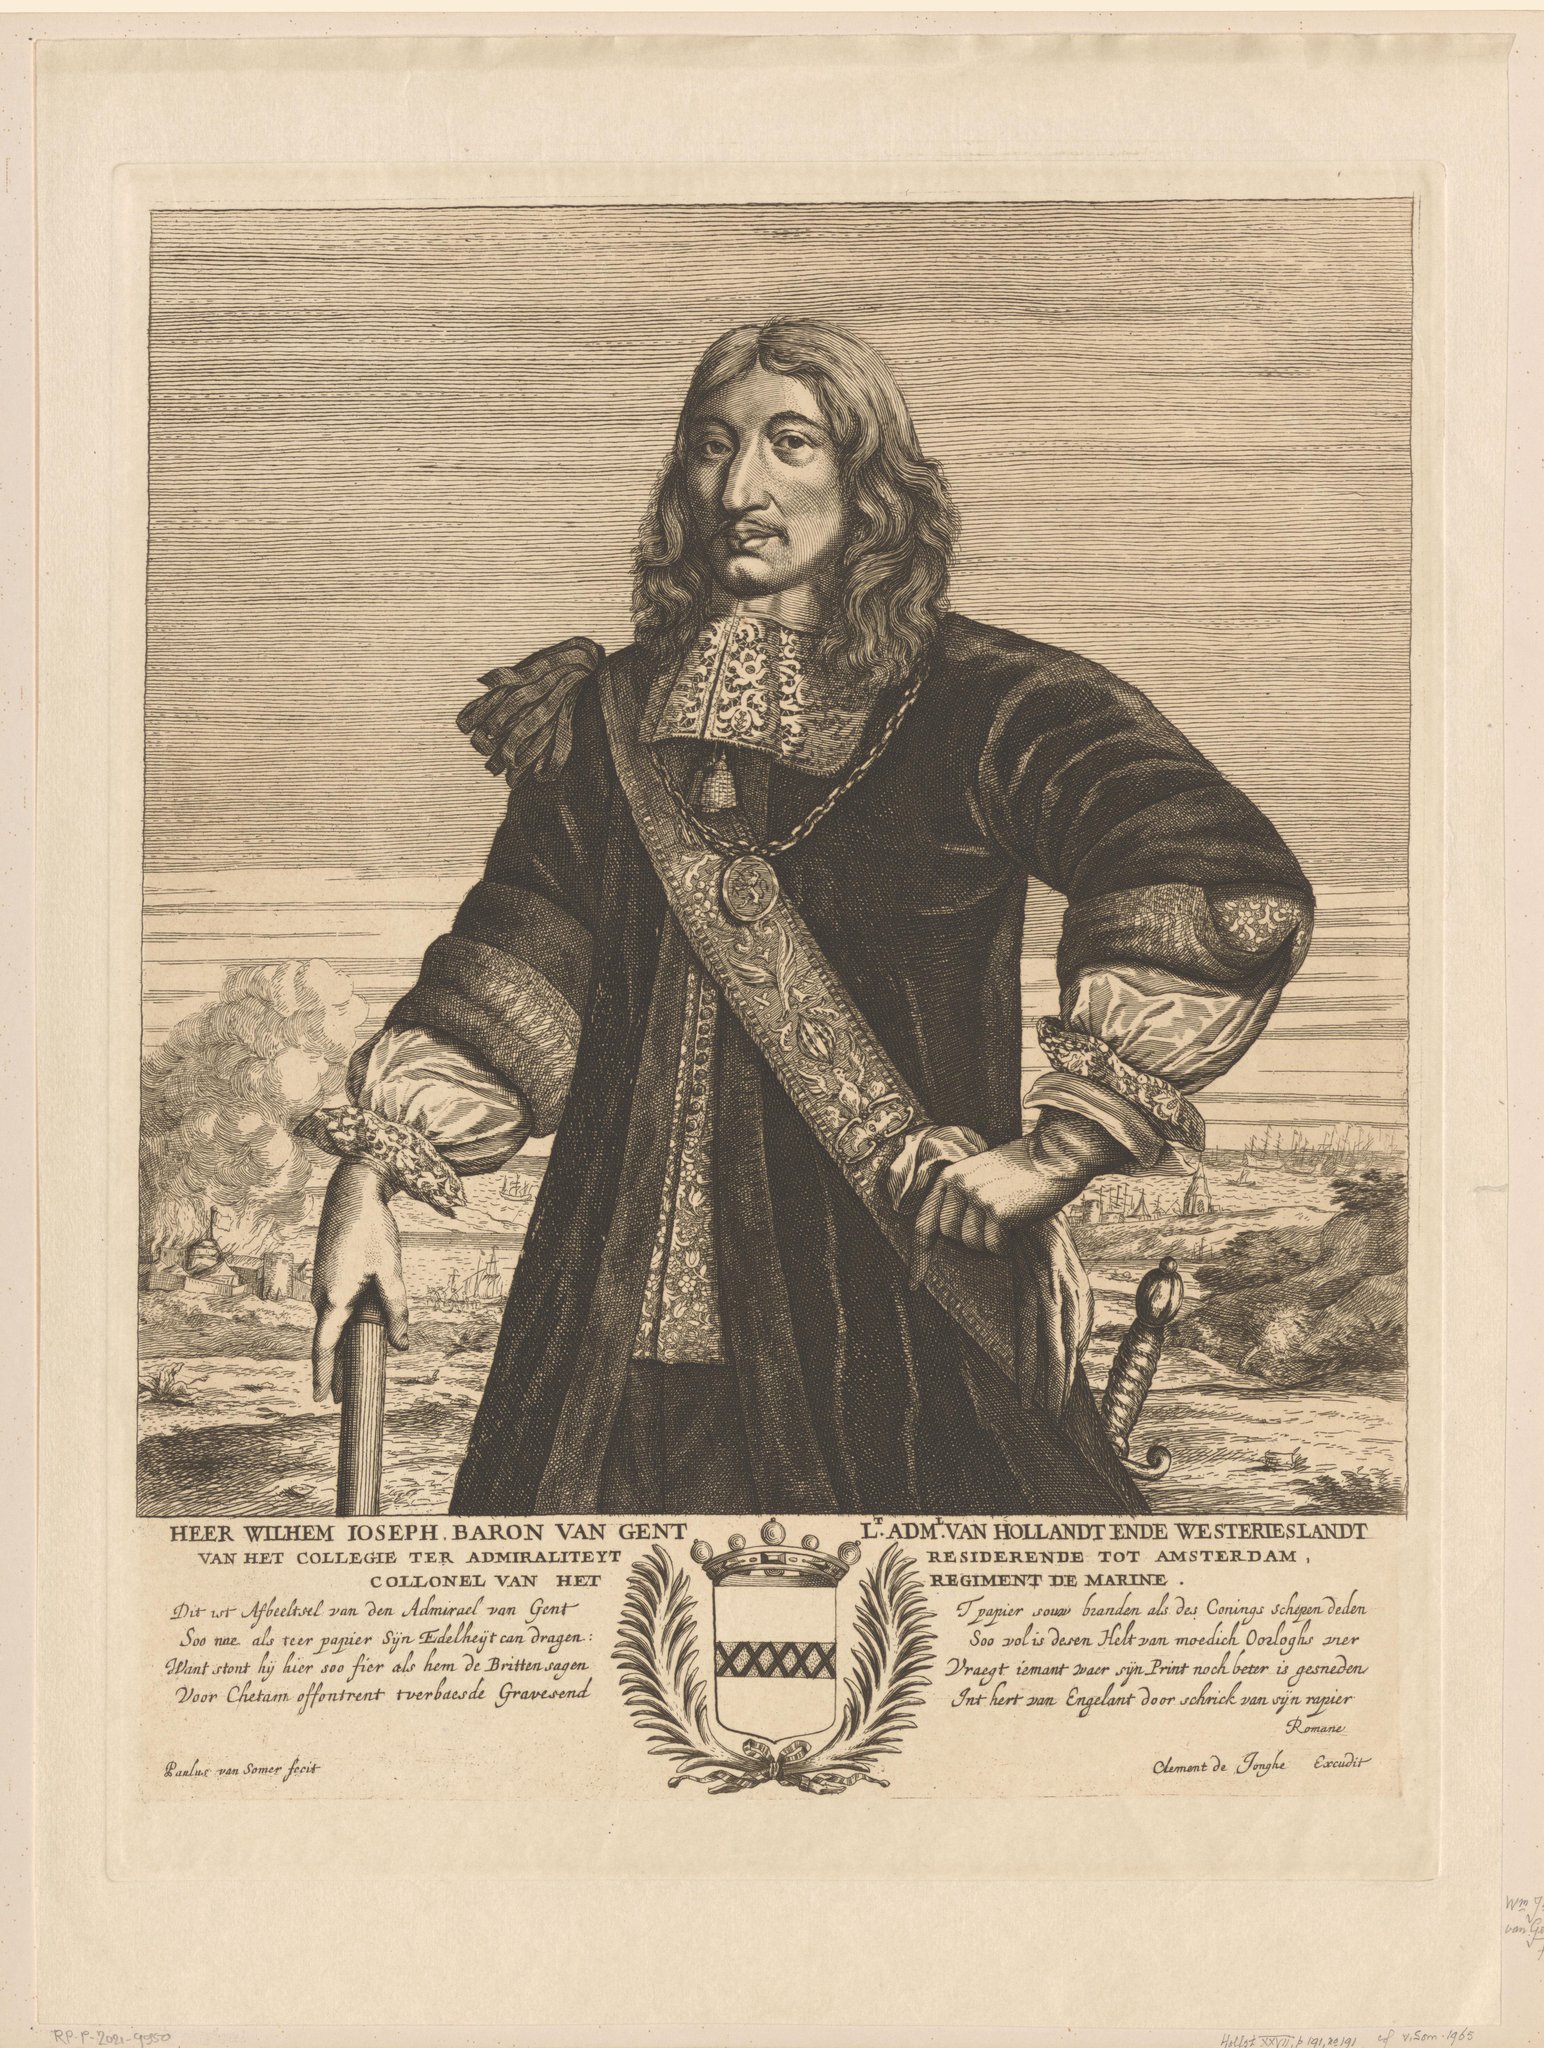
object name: photomechanical print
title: Portret van Willem Joseph baron van Gendt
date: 1920-1930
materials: paper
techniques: photoaquatint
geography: berlin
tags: willem joseph baron van gendt, historical persons, armorial bearing, heraldry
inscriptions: collector's mark: Lugt 4925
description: Onder het portret zijn wapenschild en een achtregelig vers.